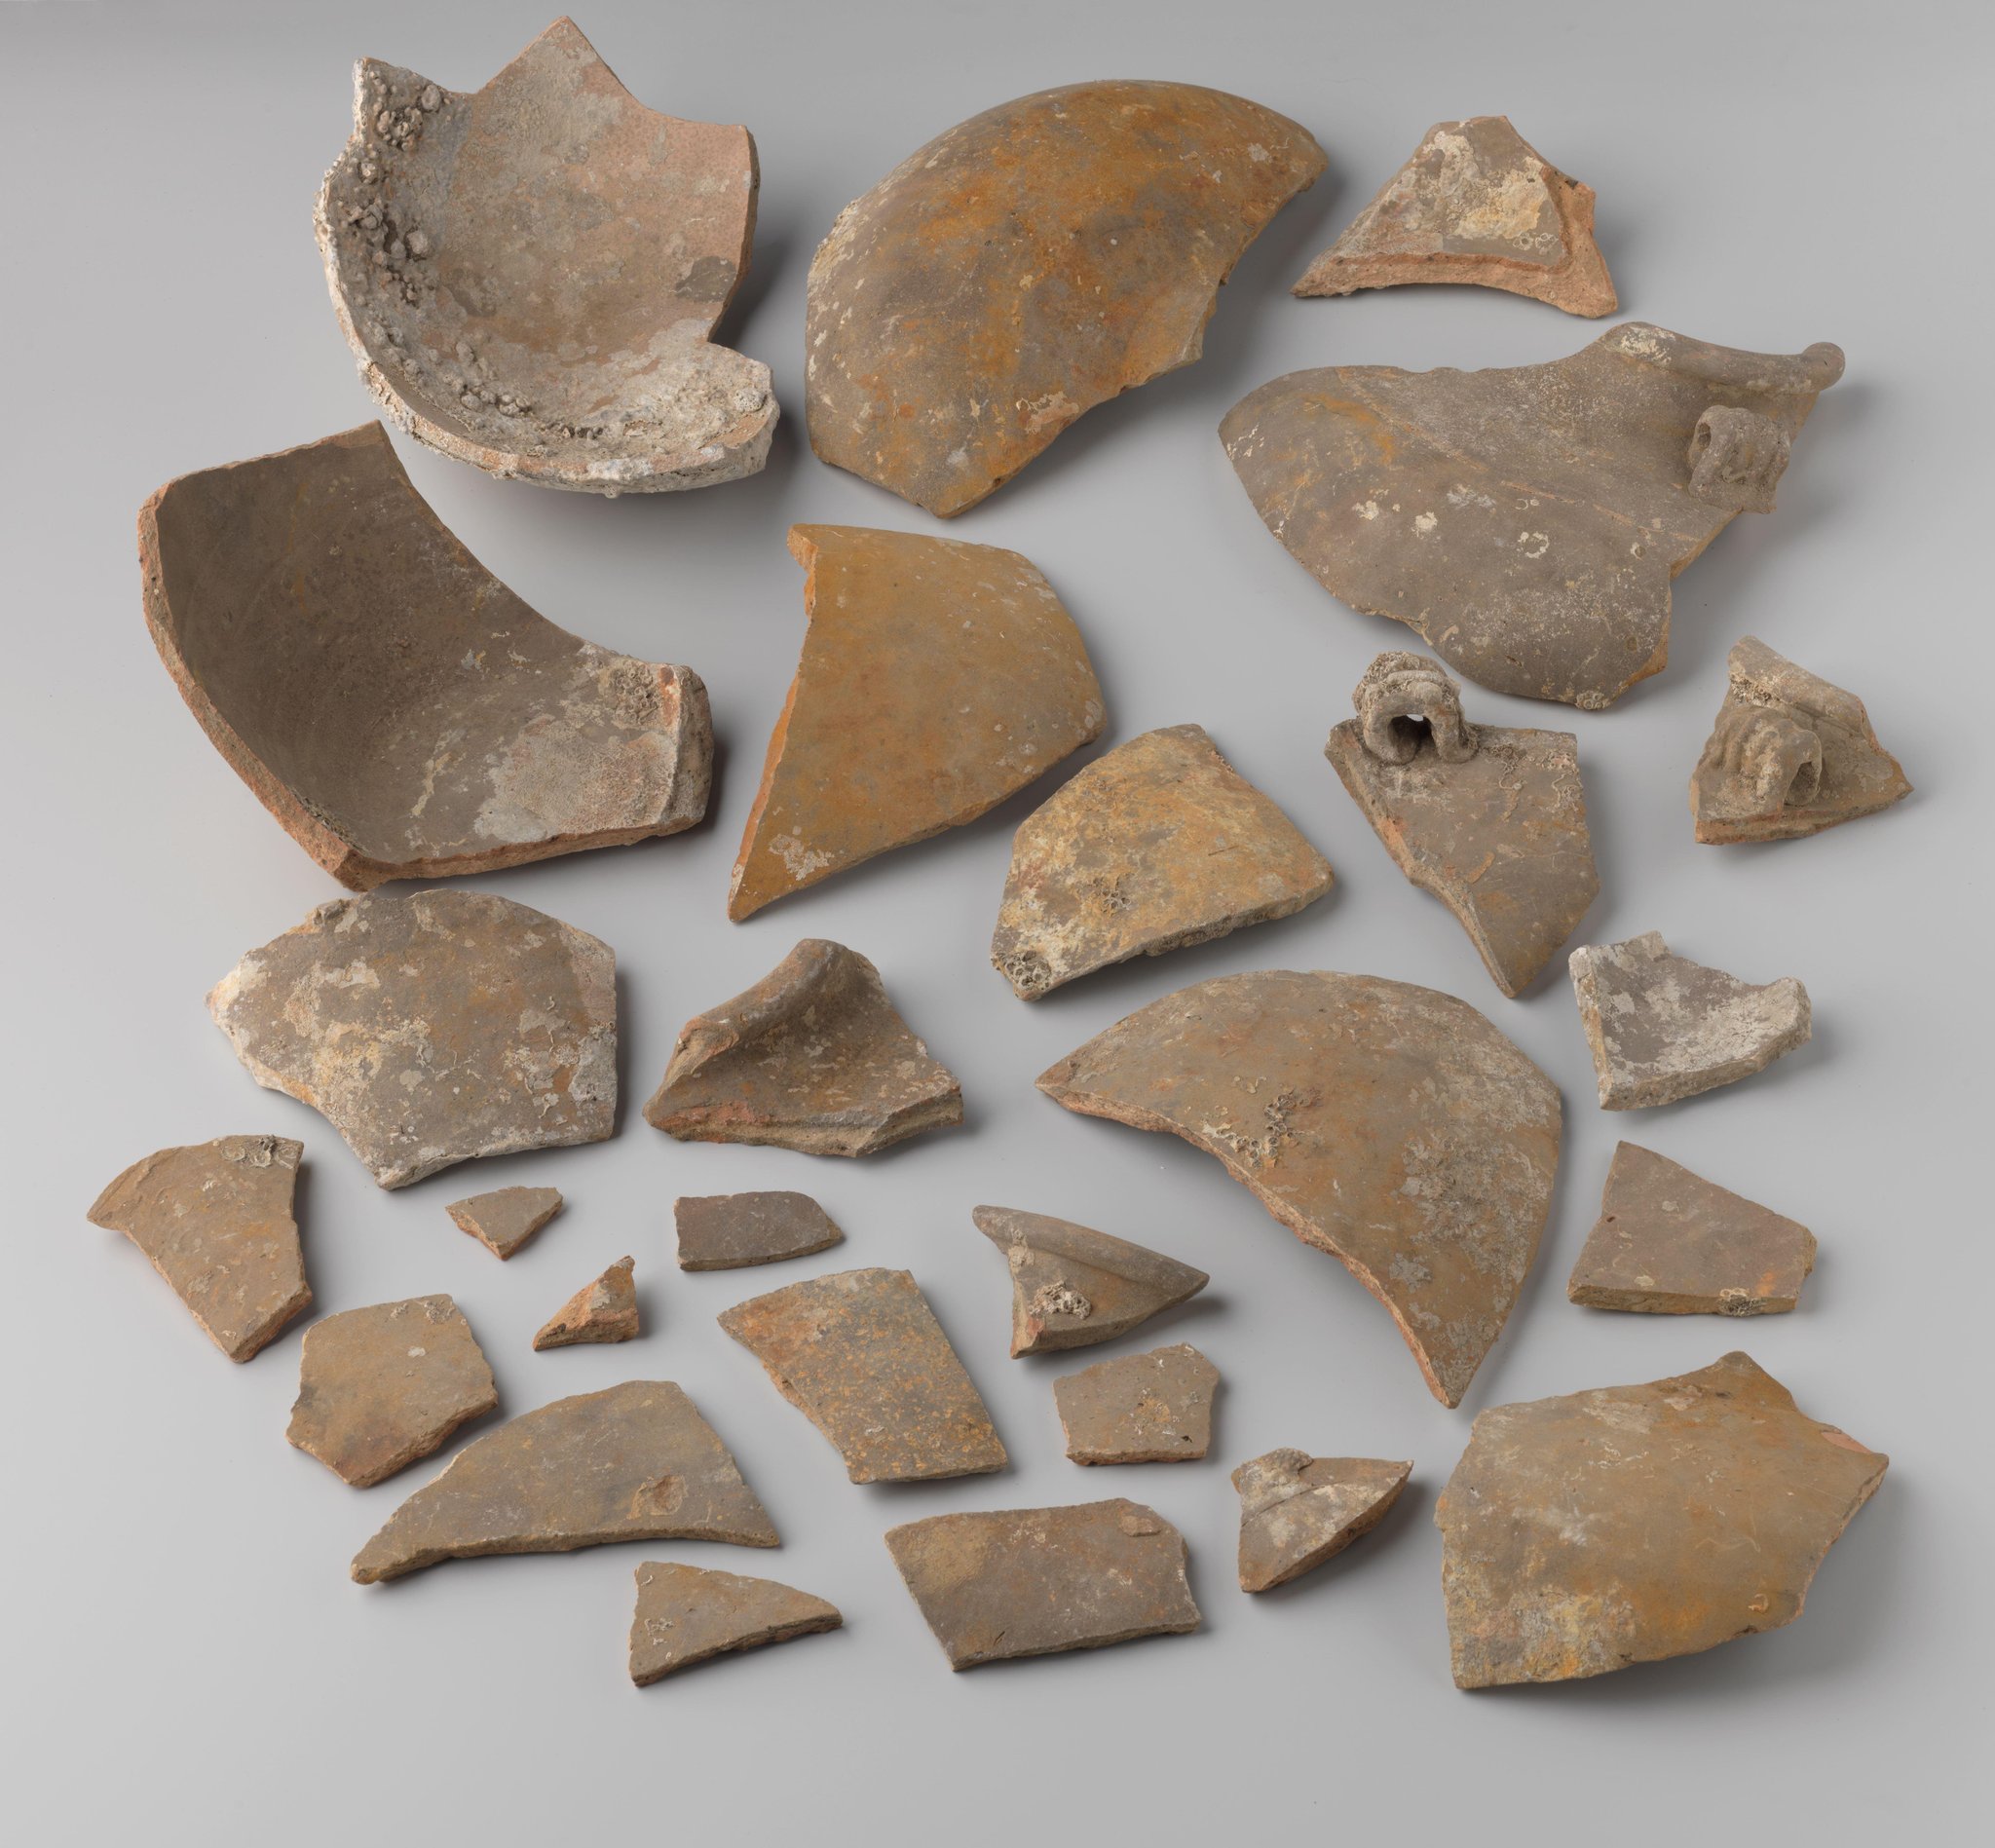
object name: martavaan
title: Scherven van martavanen uit V.O.C.-schip de 'Witte Leeuw'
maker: Anonymous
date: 1613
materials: porcelain, stoneware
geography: southeast asia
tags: verenigde oostindische compagnie, sint-helena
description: A jar. The lip is flattened and the base is roughly finished. The ears are placed on a horizontal incision. The clay has black and brown impurities. The exterior of the upper half is discoloured to a brownish yellow and a reddish brown. The surface on the inside is coloured re-brown from the shoulder joint to the lip. Base and lower half of the walls have brownish yellow discolourations.